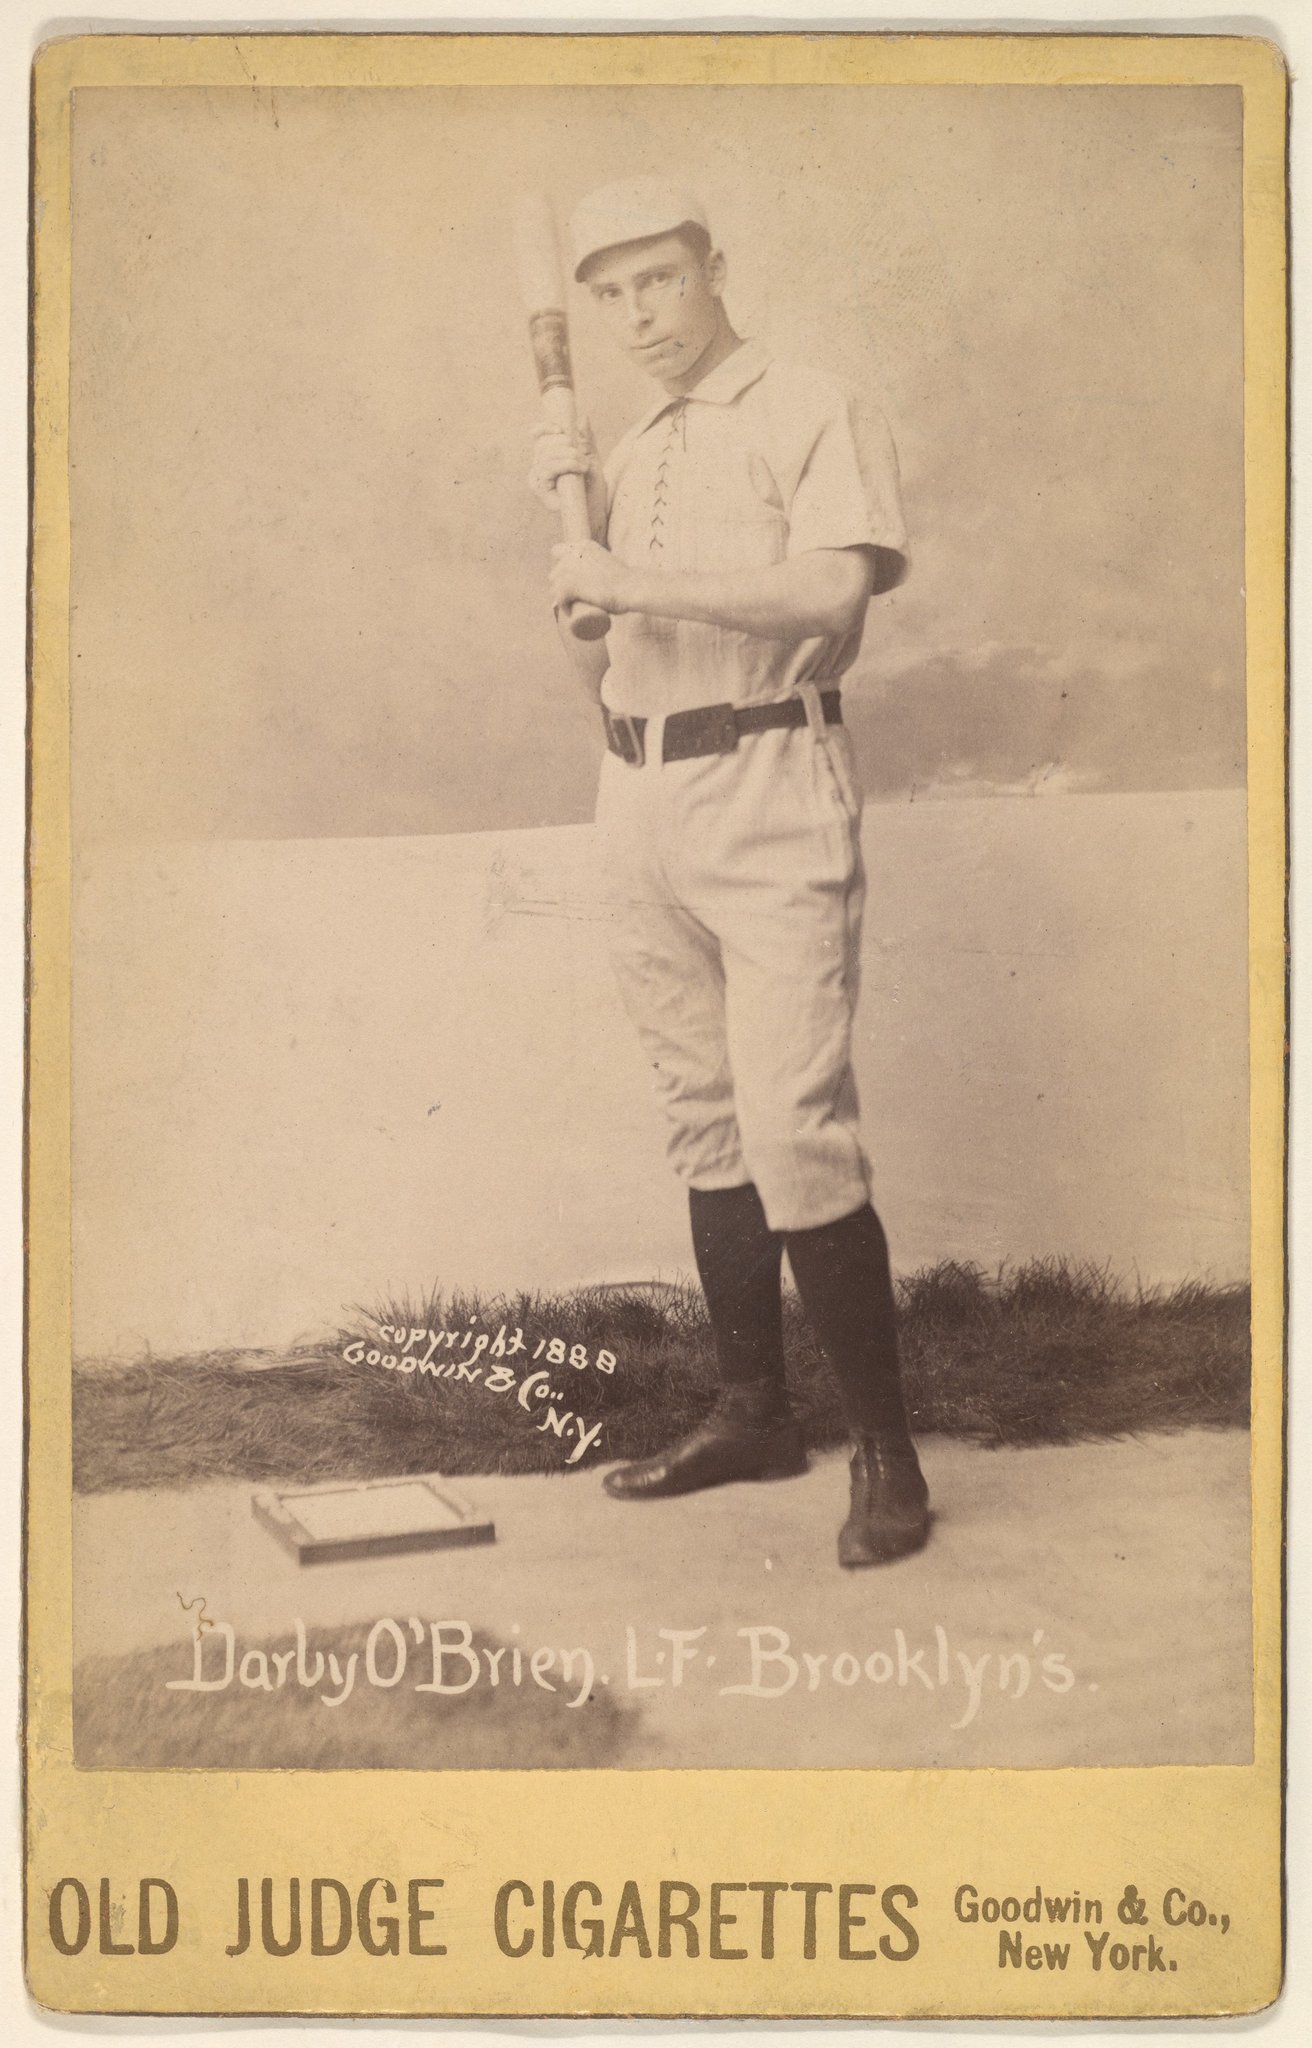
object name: baseball card, photograph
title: Darby O'Brien, Left Field, Brooklyn, from the series Old Judge Cigarettes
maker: goodwin & company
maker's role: publisher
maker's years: 1850-1950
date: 1888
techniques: albumen silver print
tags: men,portraits,baseball,athletes